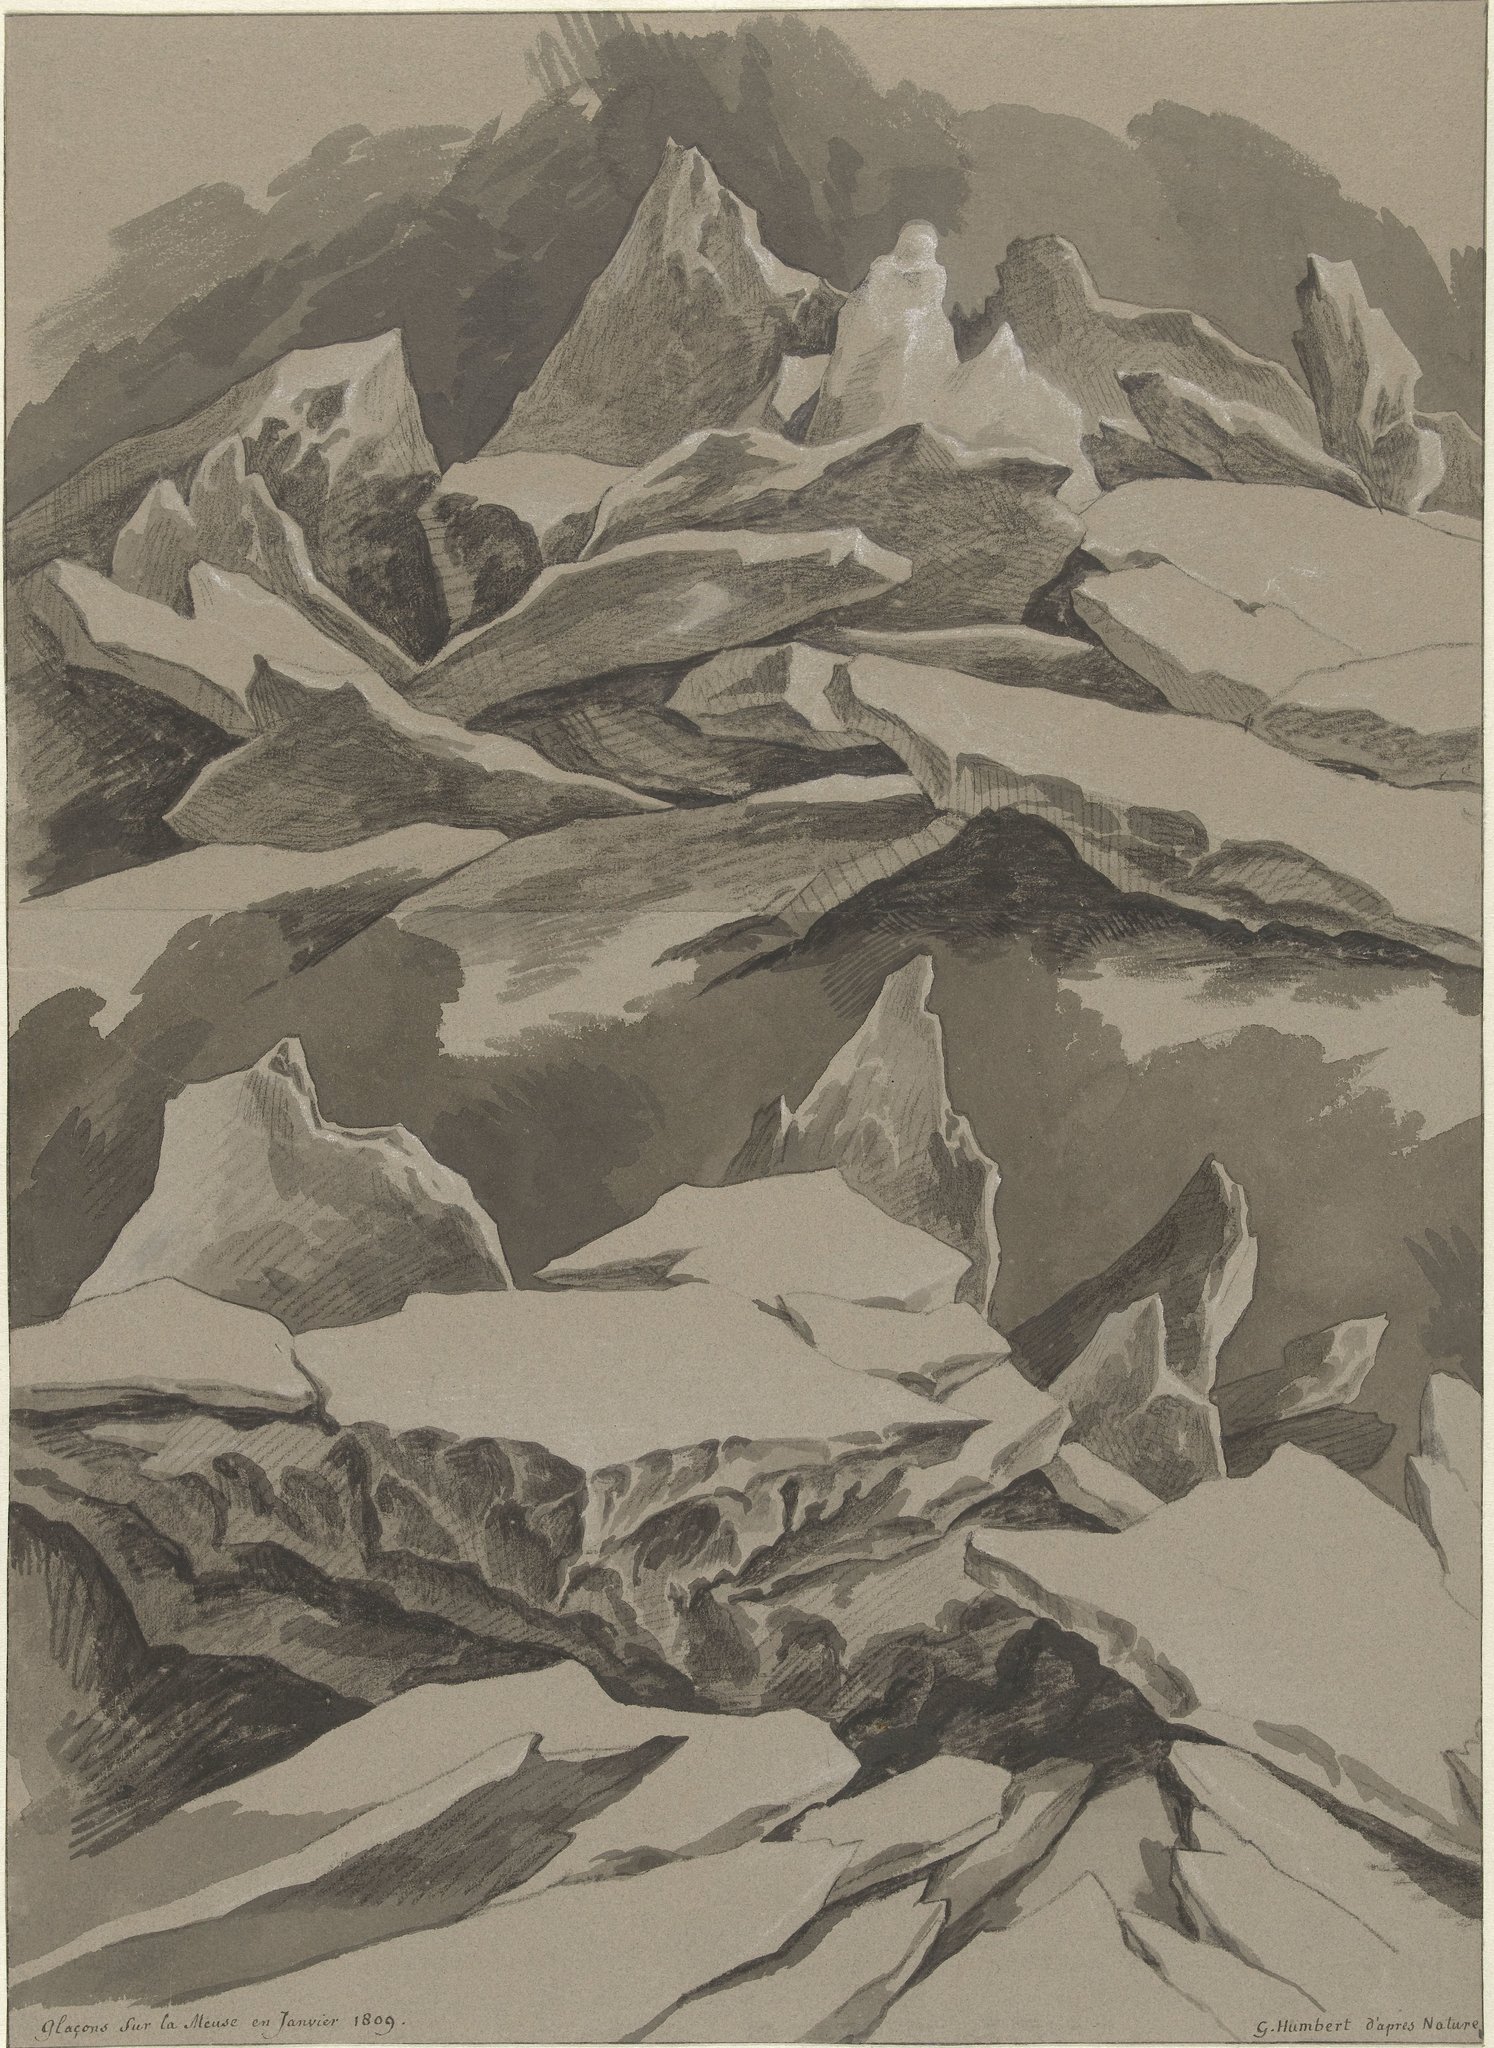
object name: drawing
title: IJsschotsen op de Maas, januari 1809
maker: david pièrre giottino humbert de superville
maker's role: draughtsman, painter, print maker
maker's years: 1770-1849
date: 1801-1809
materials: chalk, paper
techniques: brush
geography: netherlands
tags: drift ice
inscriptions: inscription: ‘Glaçons sur la Meuse en Janvier 1809 / G. Humbert d'apres Nature’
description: Twee afbeeldingen van het kruiende ijs langs de Maas, januari 1809.